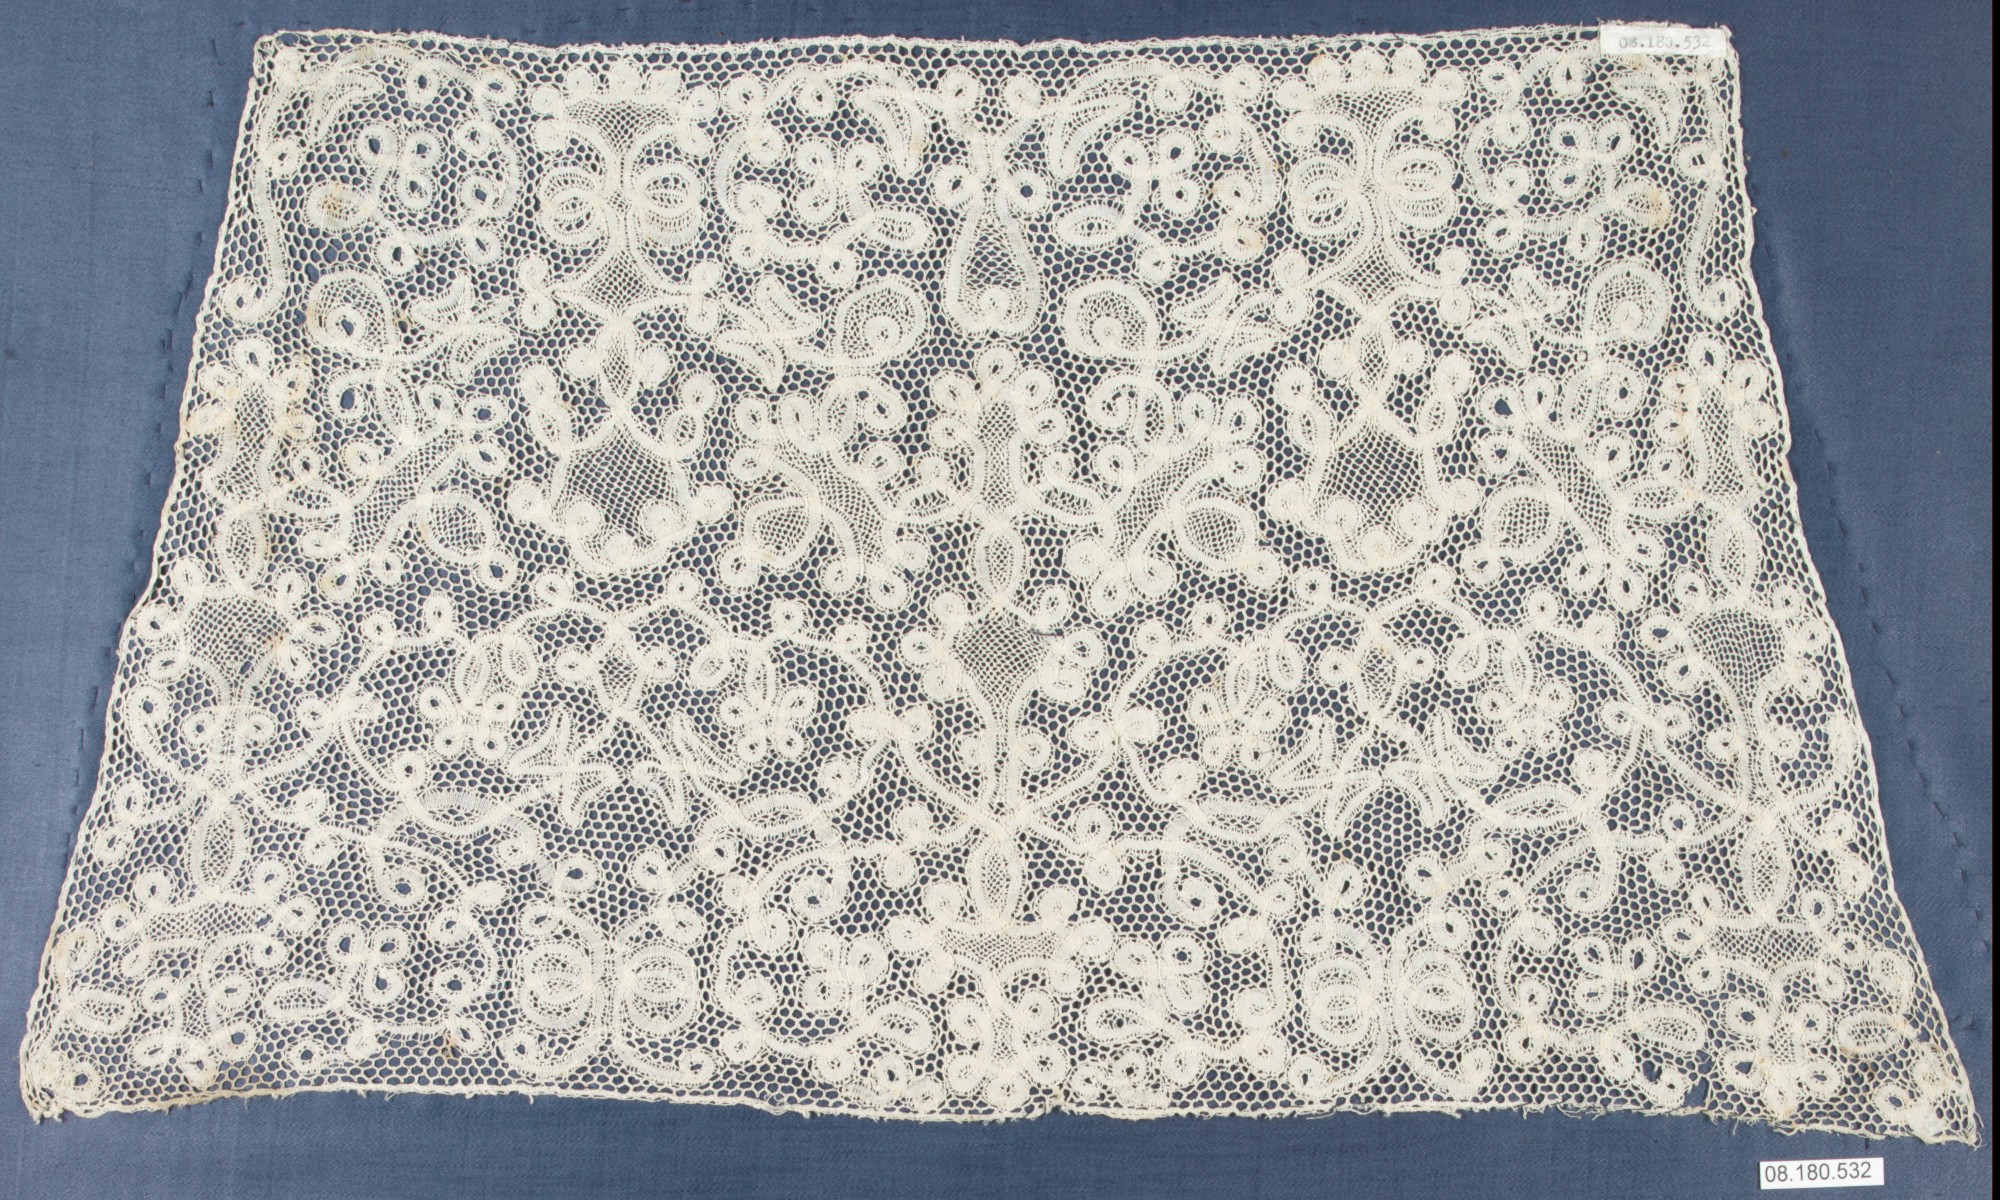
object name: rabat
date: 1667-1733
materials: lace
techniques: lace